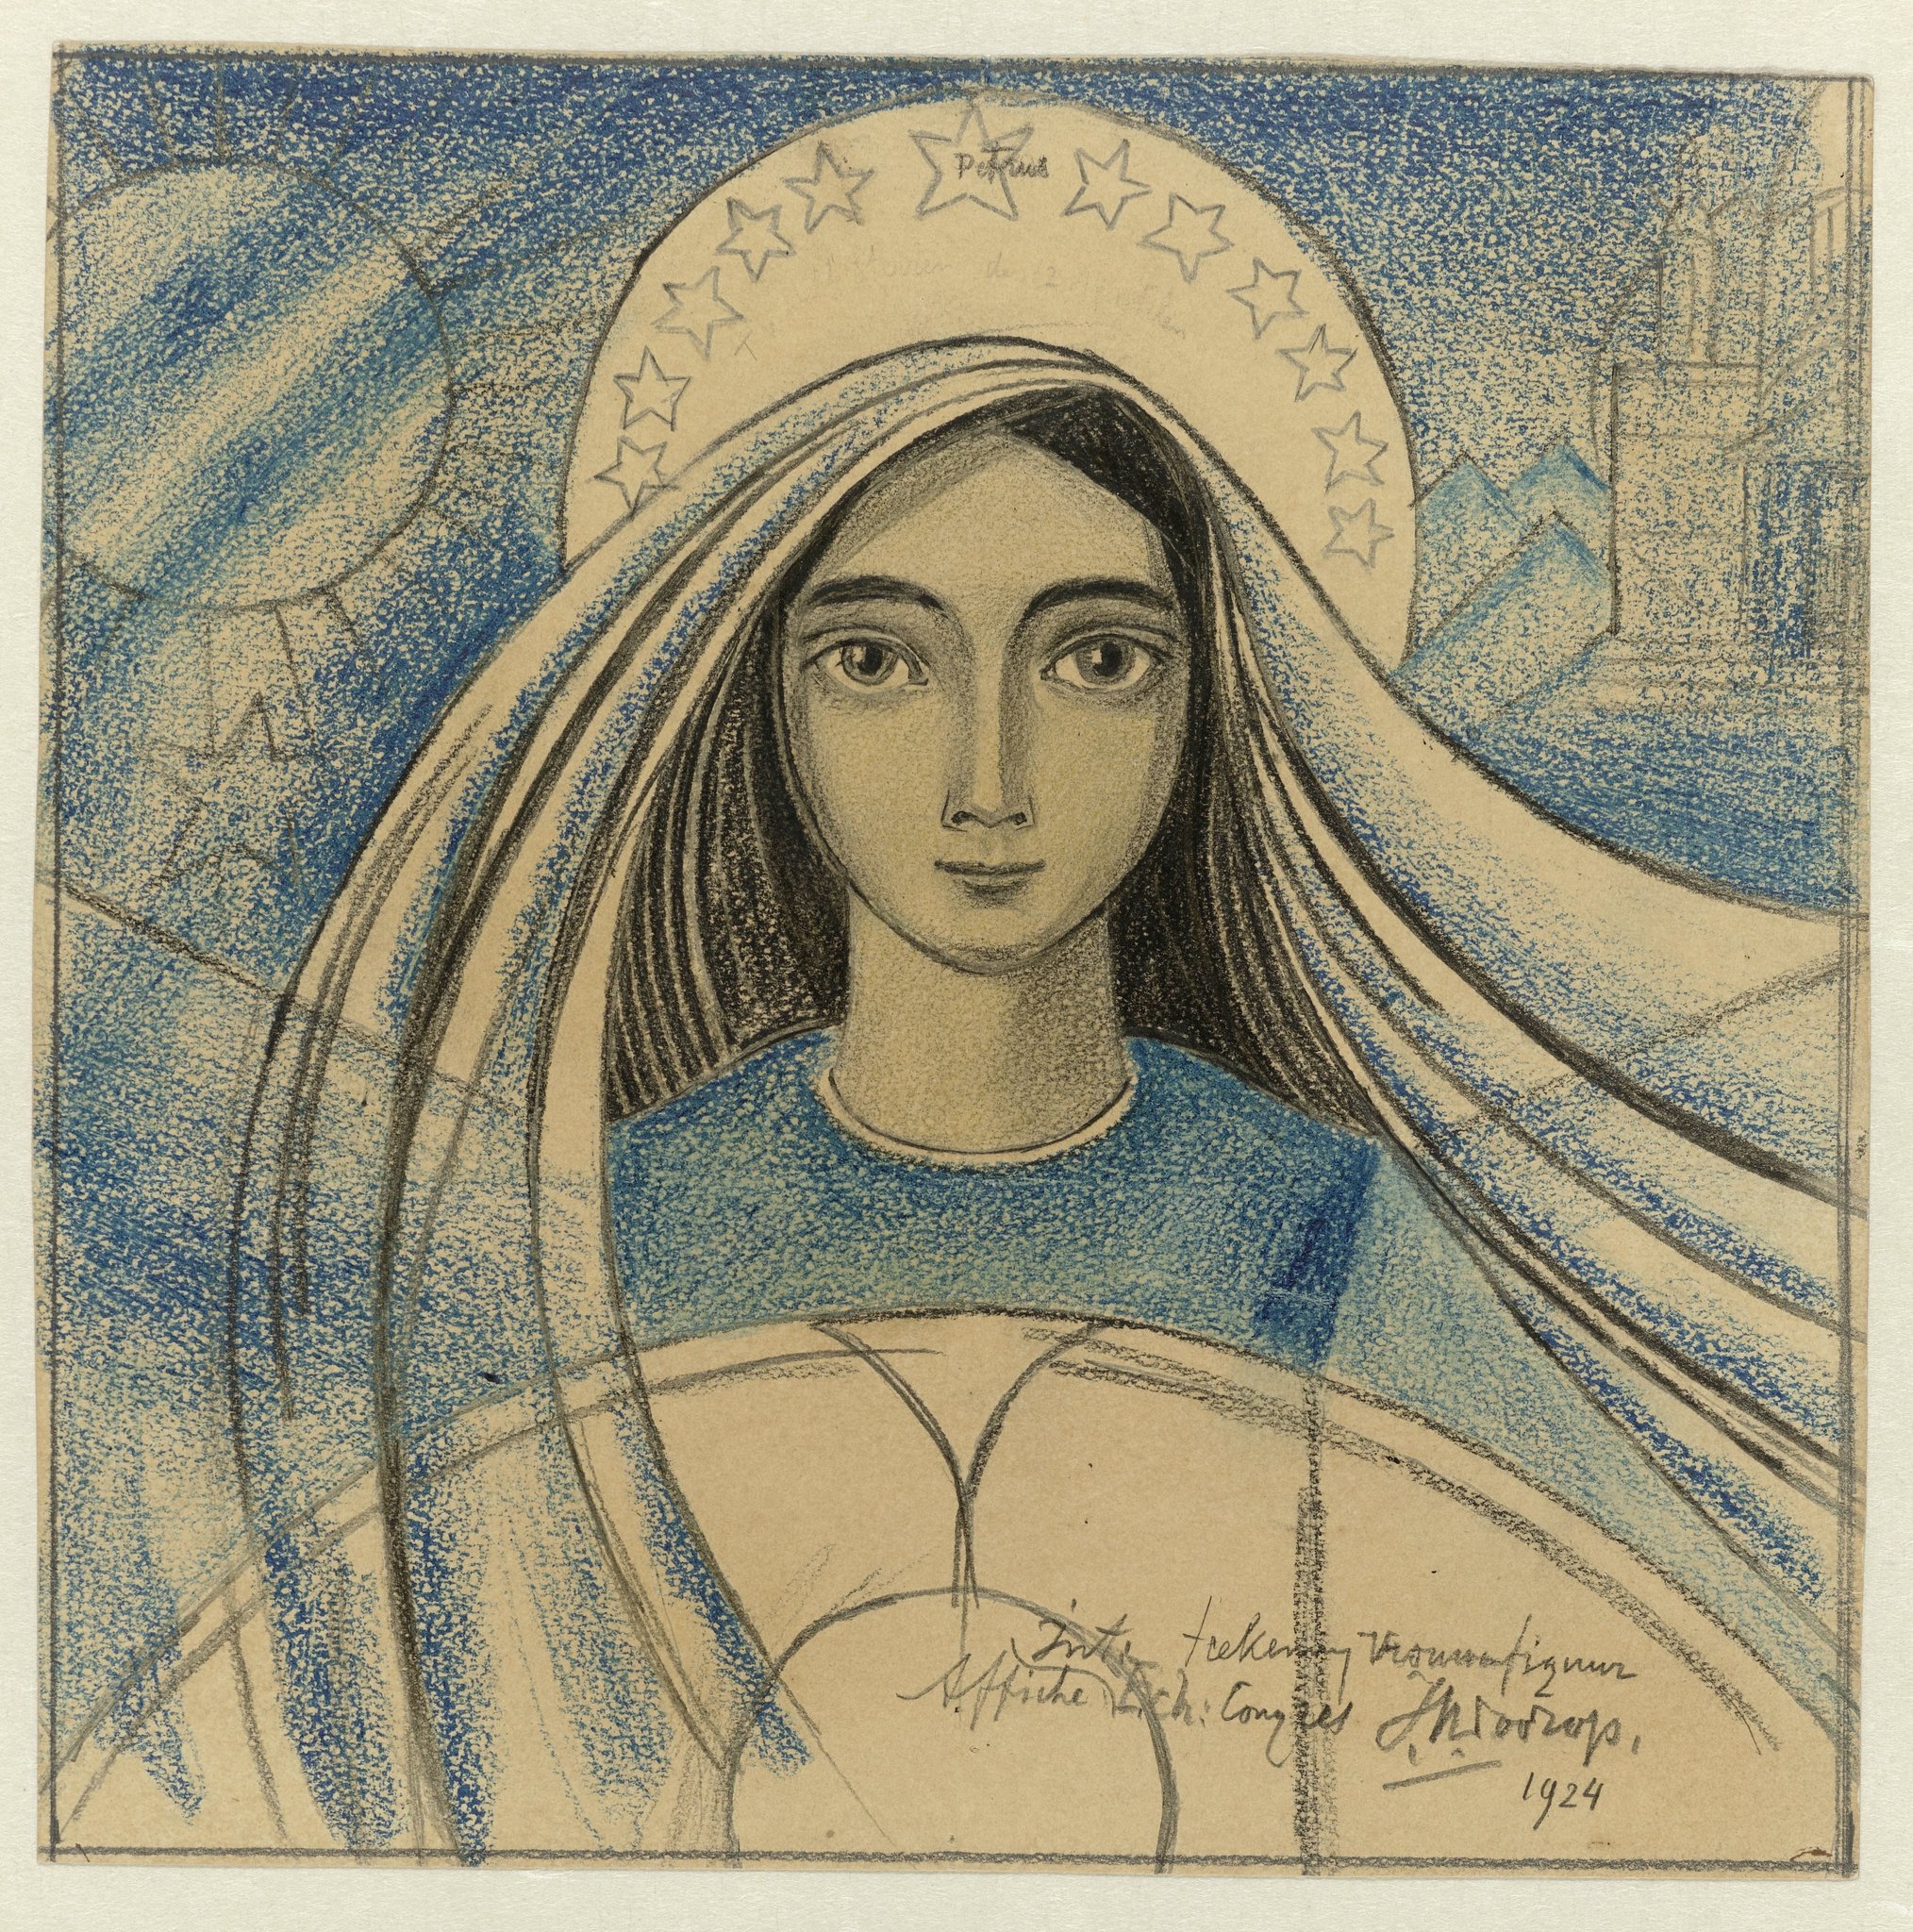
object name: drawing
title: Detailontwerp van een vrouwenhoofd voor een affiche voor het Internationaal Eucharistisch Congres gehouden te Amsterdam van 22-27 juli 1924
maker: jan toorop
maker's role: draughtsman, painter, print maker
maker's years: 1858-1928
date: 1924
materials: chalk, paper, pencil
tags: poster, international eucharistic congress